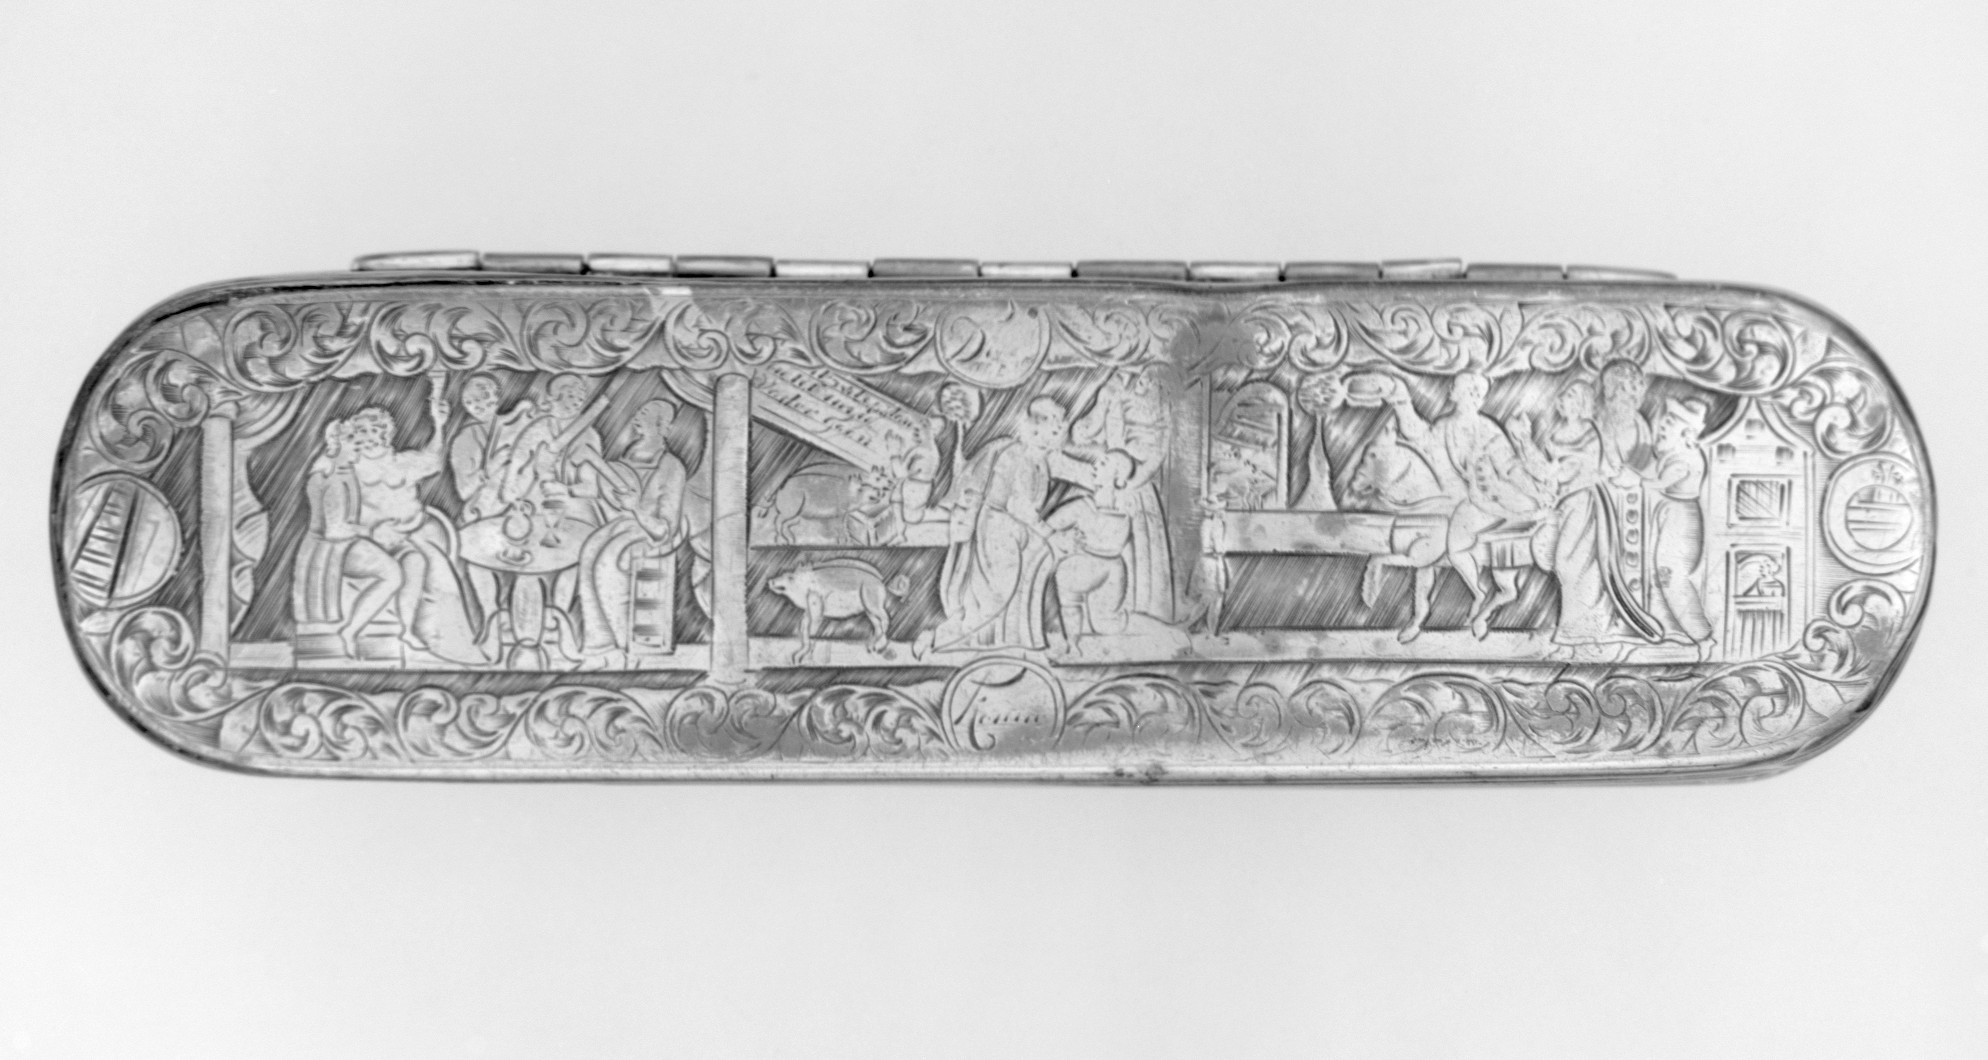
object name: tobacco box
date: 1701-1800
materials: brass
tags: men,women,horses